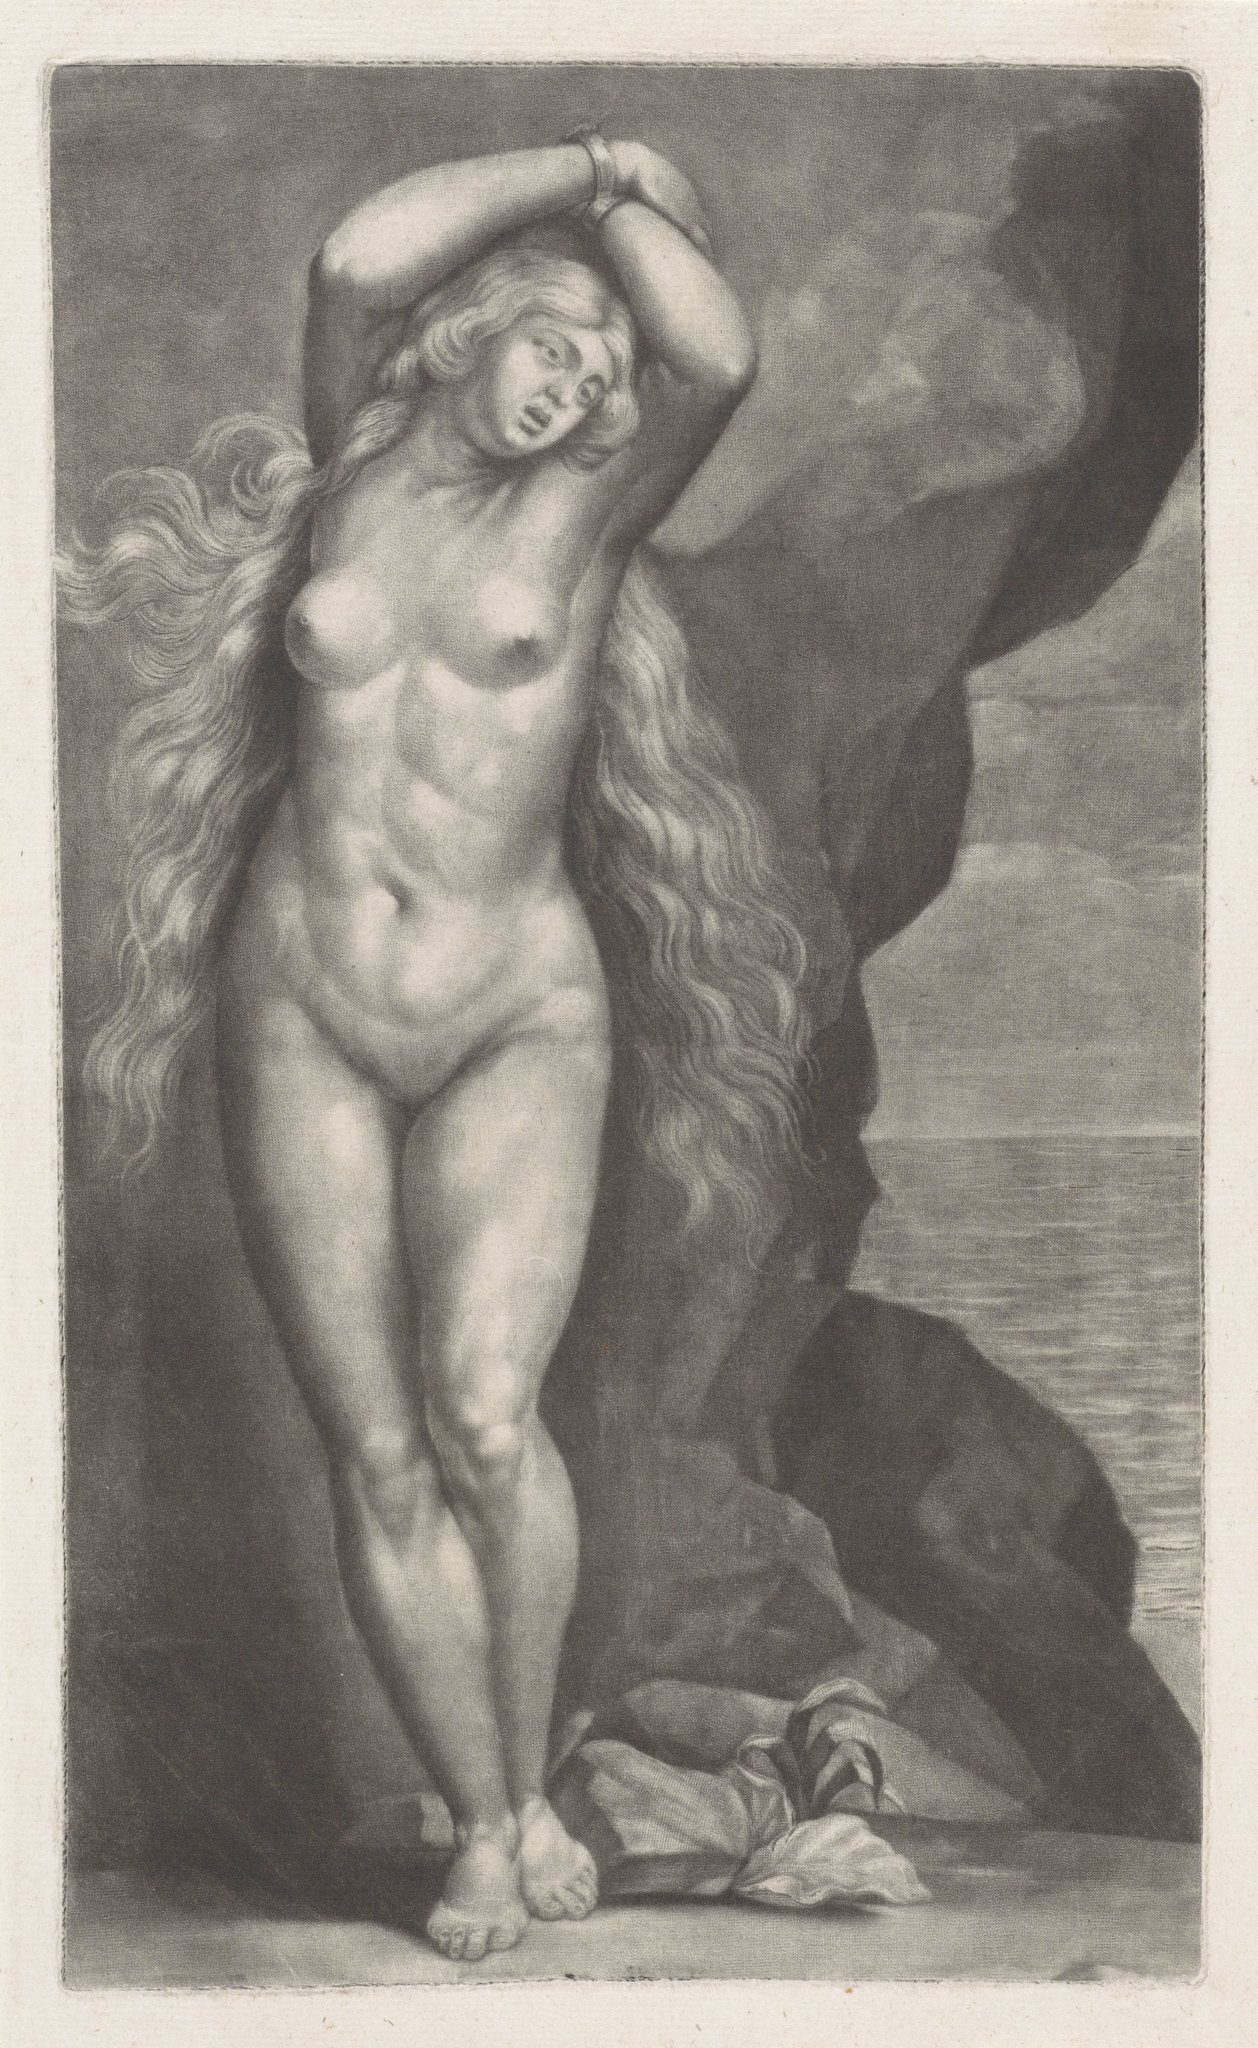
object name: print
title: Andromeda aan de rots geketend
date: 1652-1690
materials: paper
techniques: mezzotint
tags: andromeda chained to the rock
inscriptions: collector's mark: Lugt 2228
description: Andromeda, de dochter van een Ethiopische koning, is vastgeketend aan een rots bij zee, als offer aan een zeemonster. Scène uit de Metamorfosen van Ovidius.